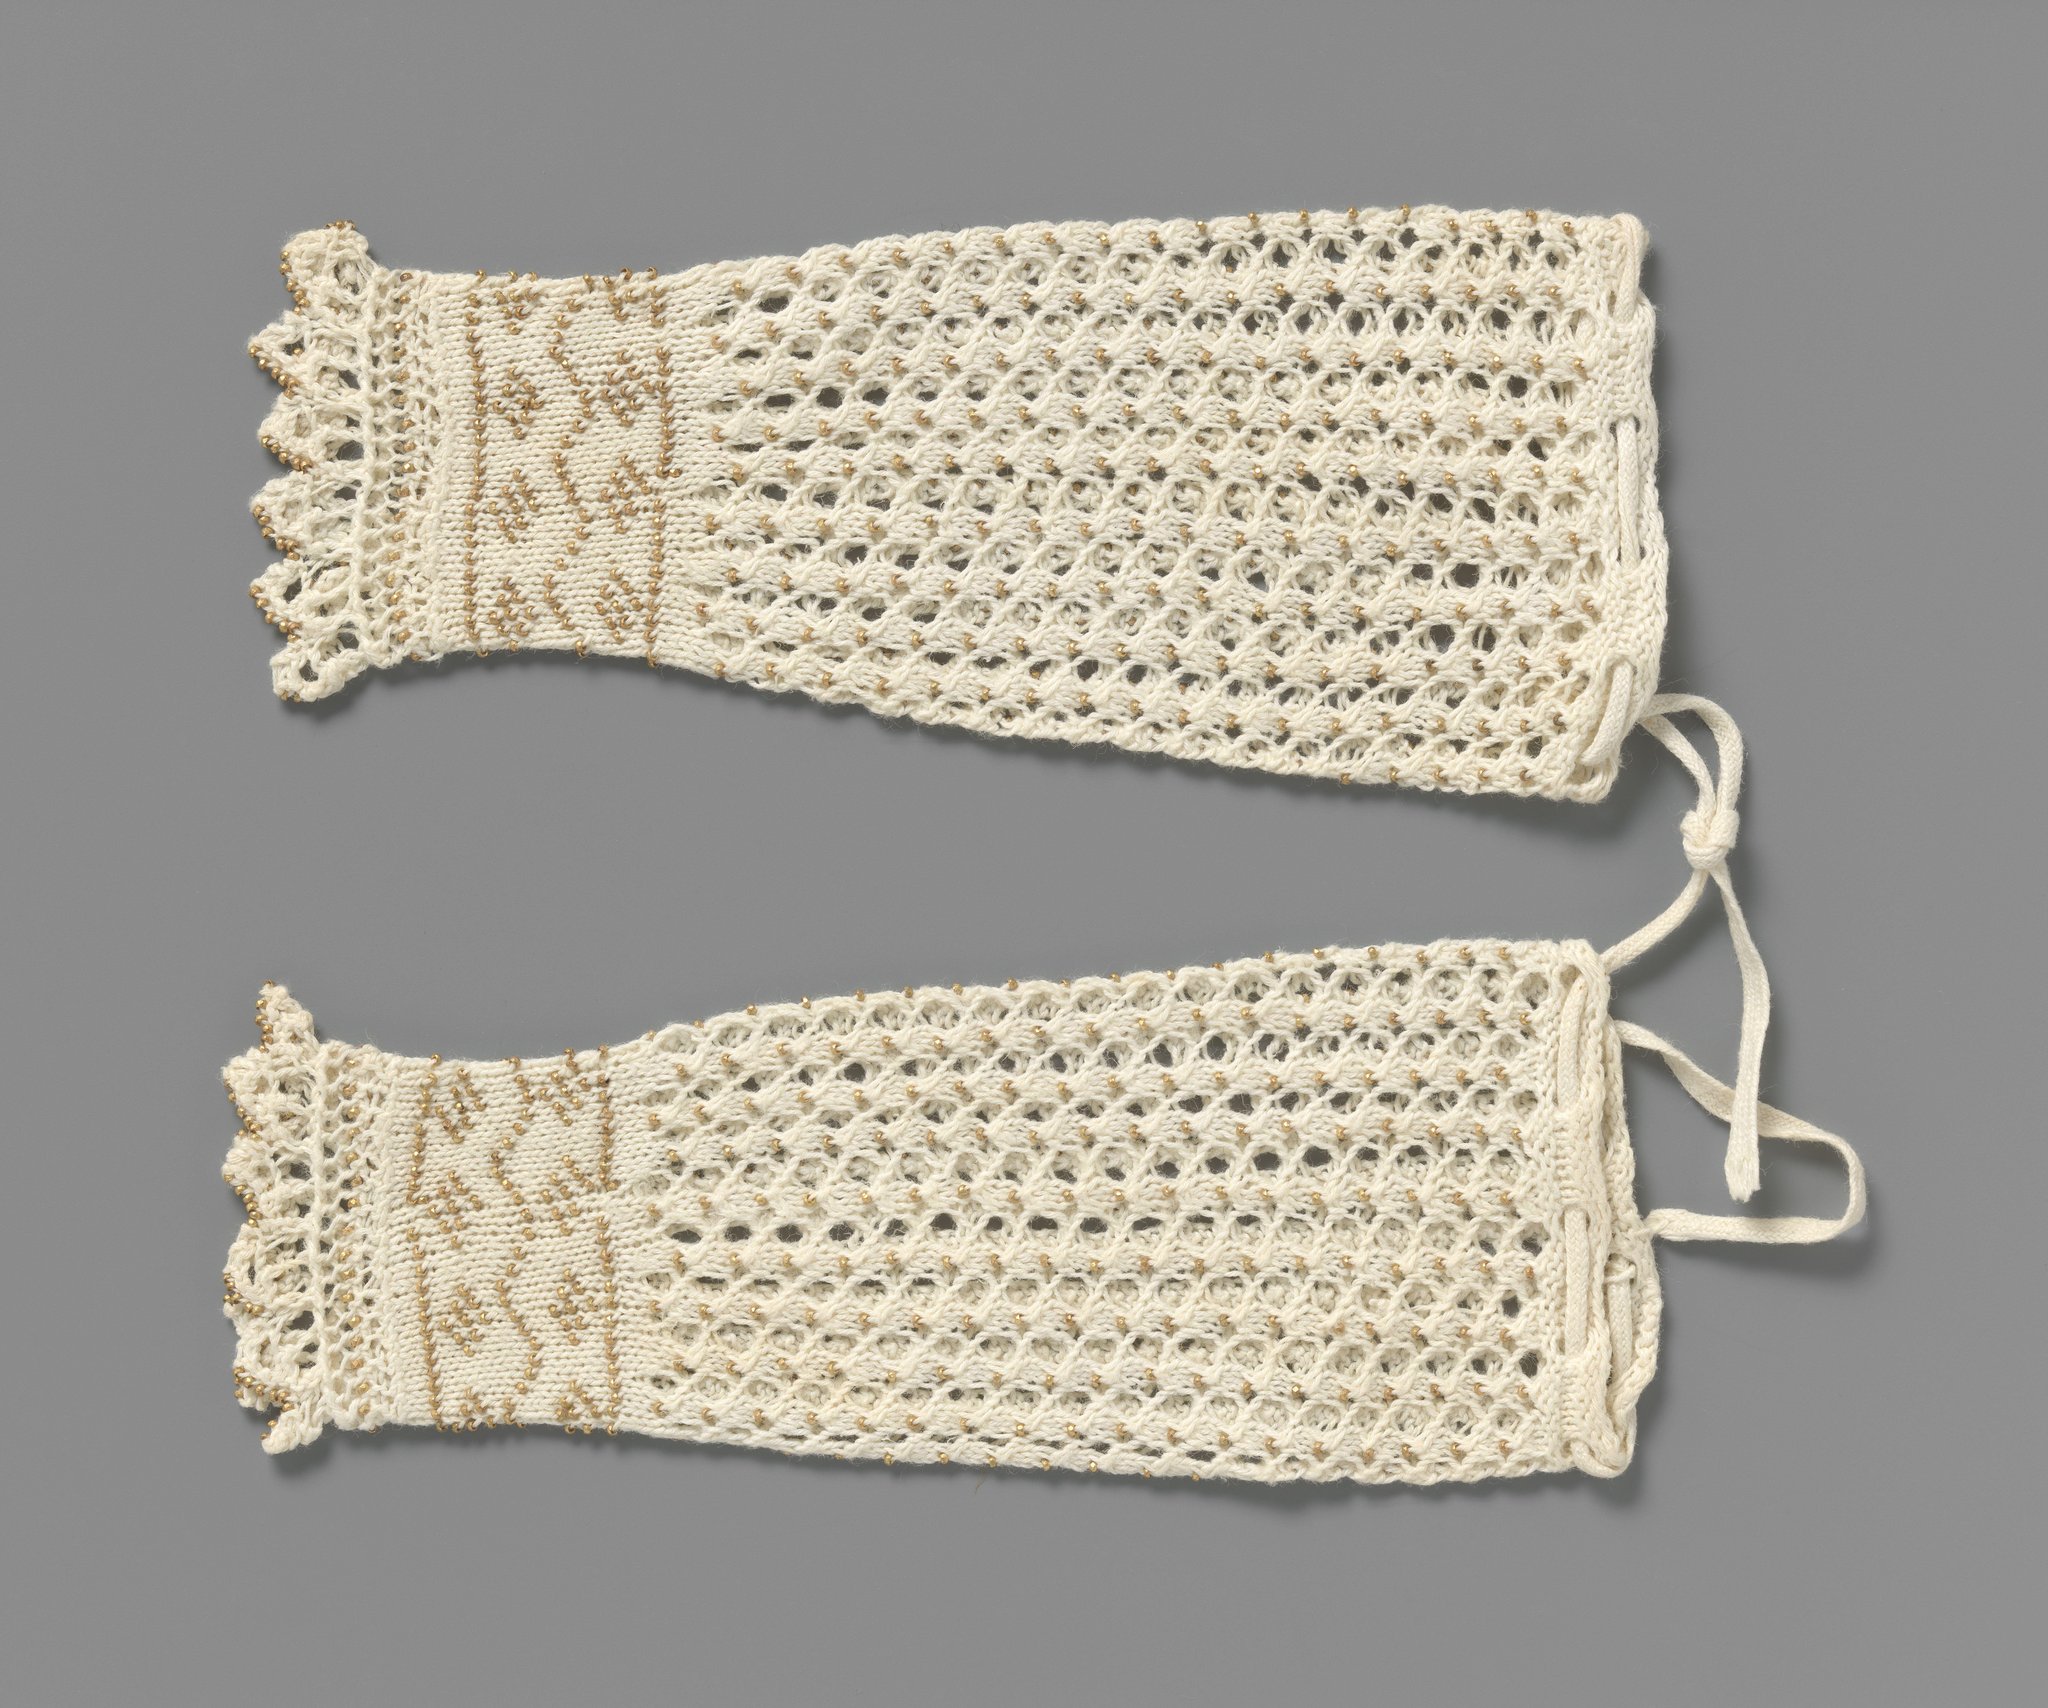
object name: childrenswear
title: Mitaine van witte gebreide katoen in ajour patroon met kralen versierd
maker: Anonymous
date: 1800-1820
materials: cotton, metal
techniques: embroidery, knitting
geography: netherlands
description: Mitaine van witte gebreide katoen in ajour patroon versierd met koperkleurige kralen, voor baby of kind. Deel van een paar.